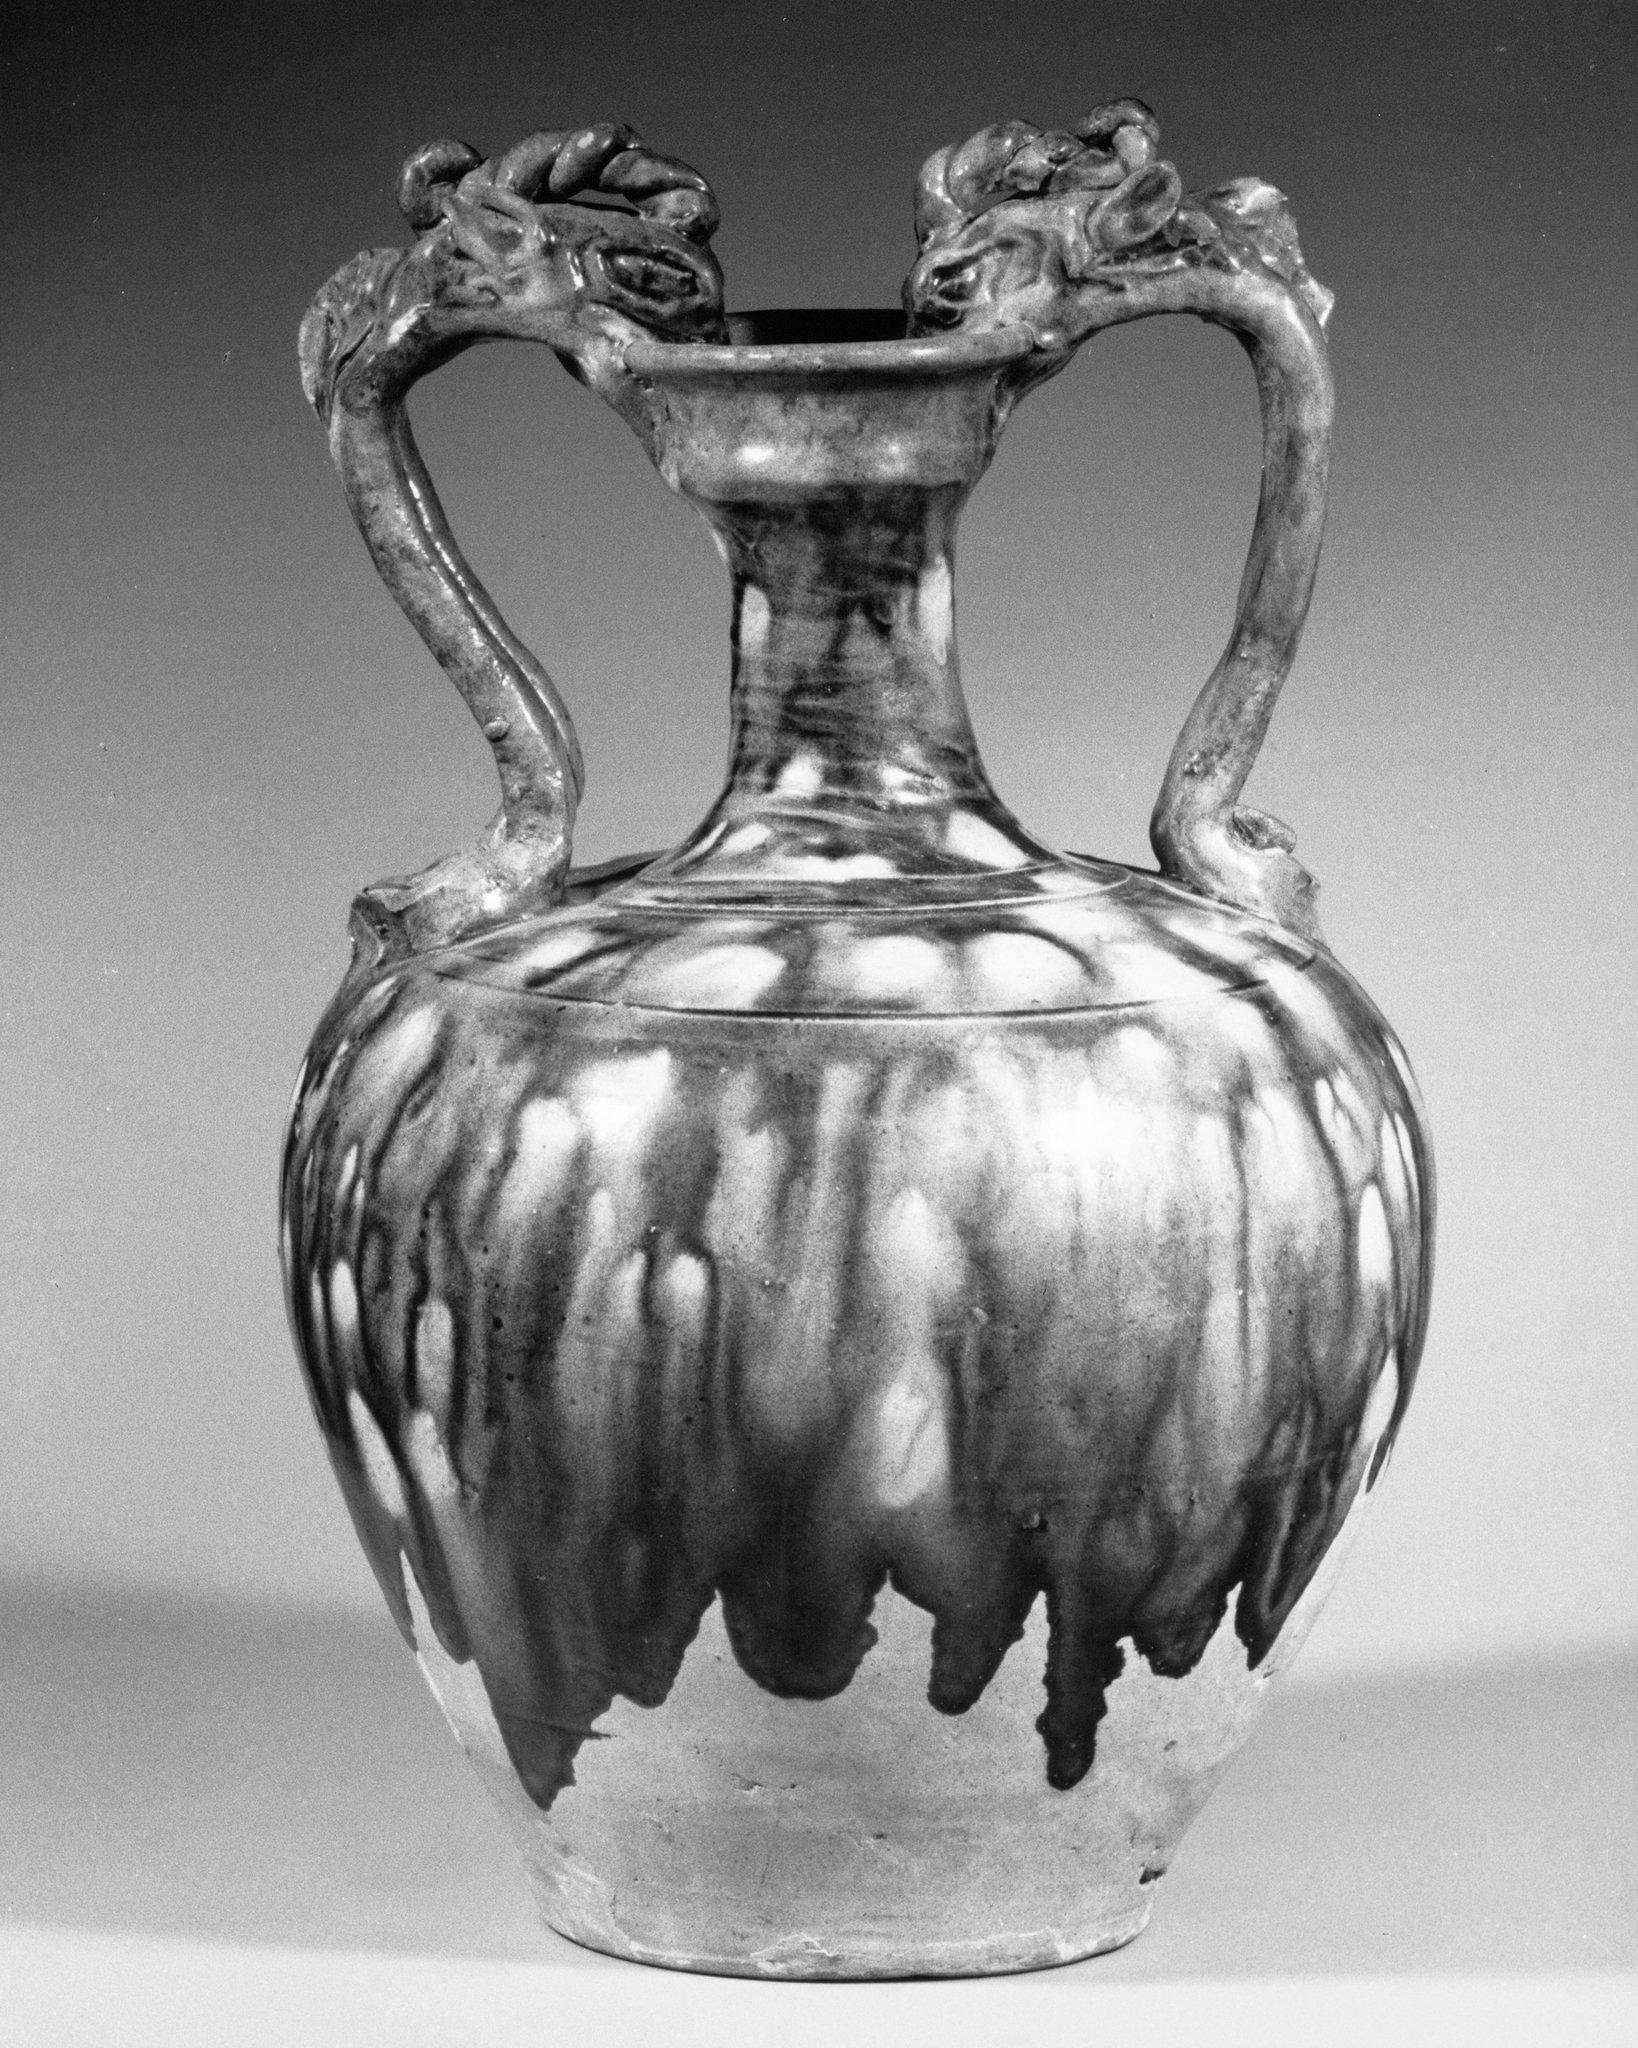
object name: amphora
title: Amphora with dragon-shaped handles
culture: chinese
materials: earthenware, glaze